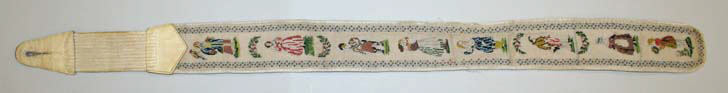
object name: suspender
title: Suspenders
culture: french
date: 1825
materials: linen, silk